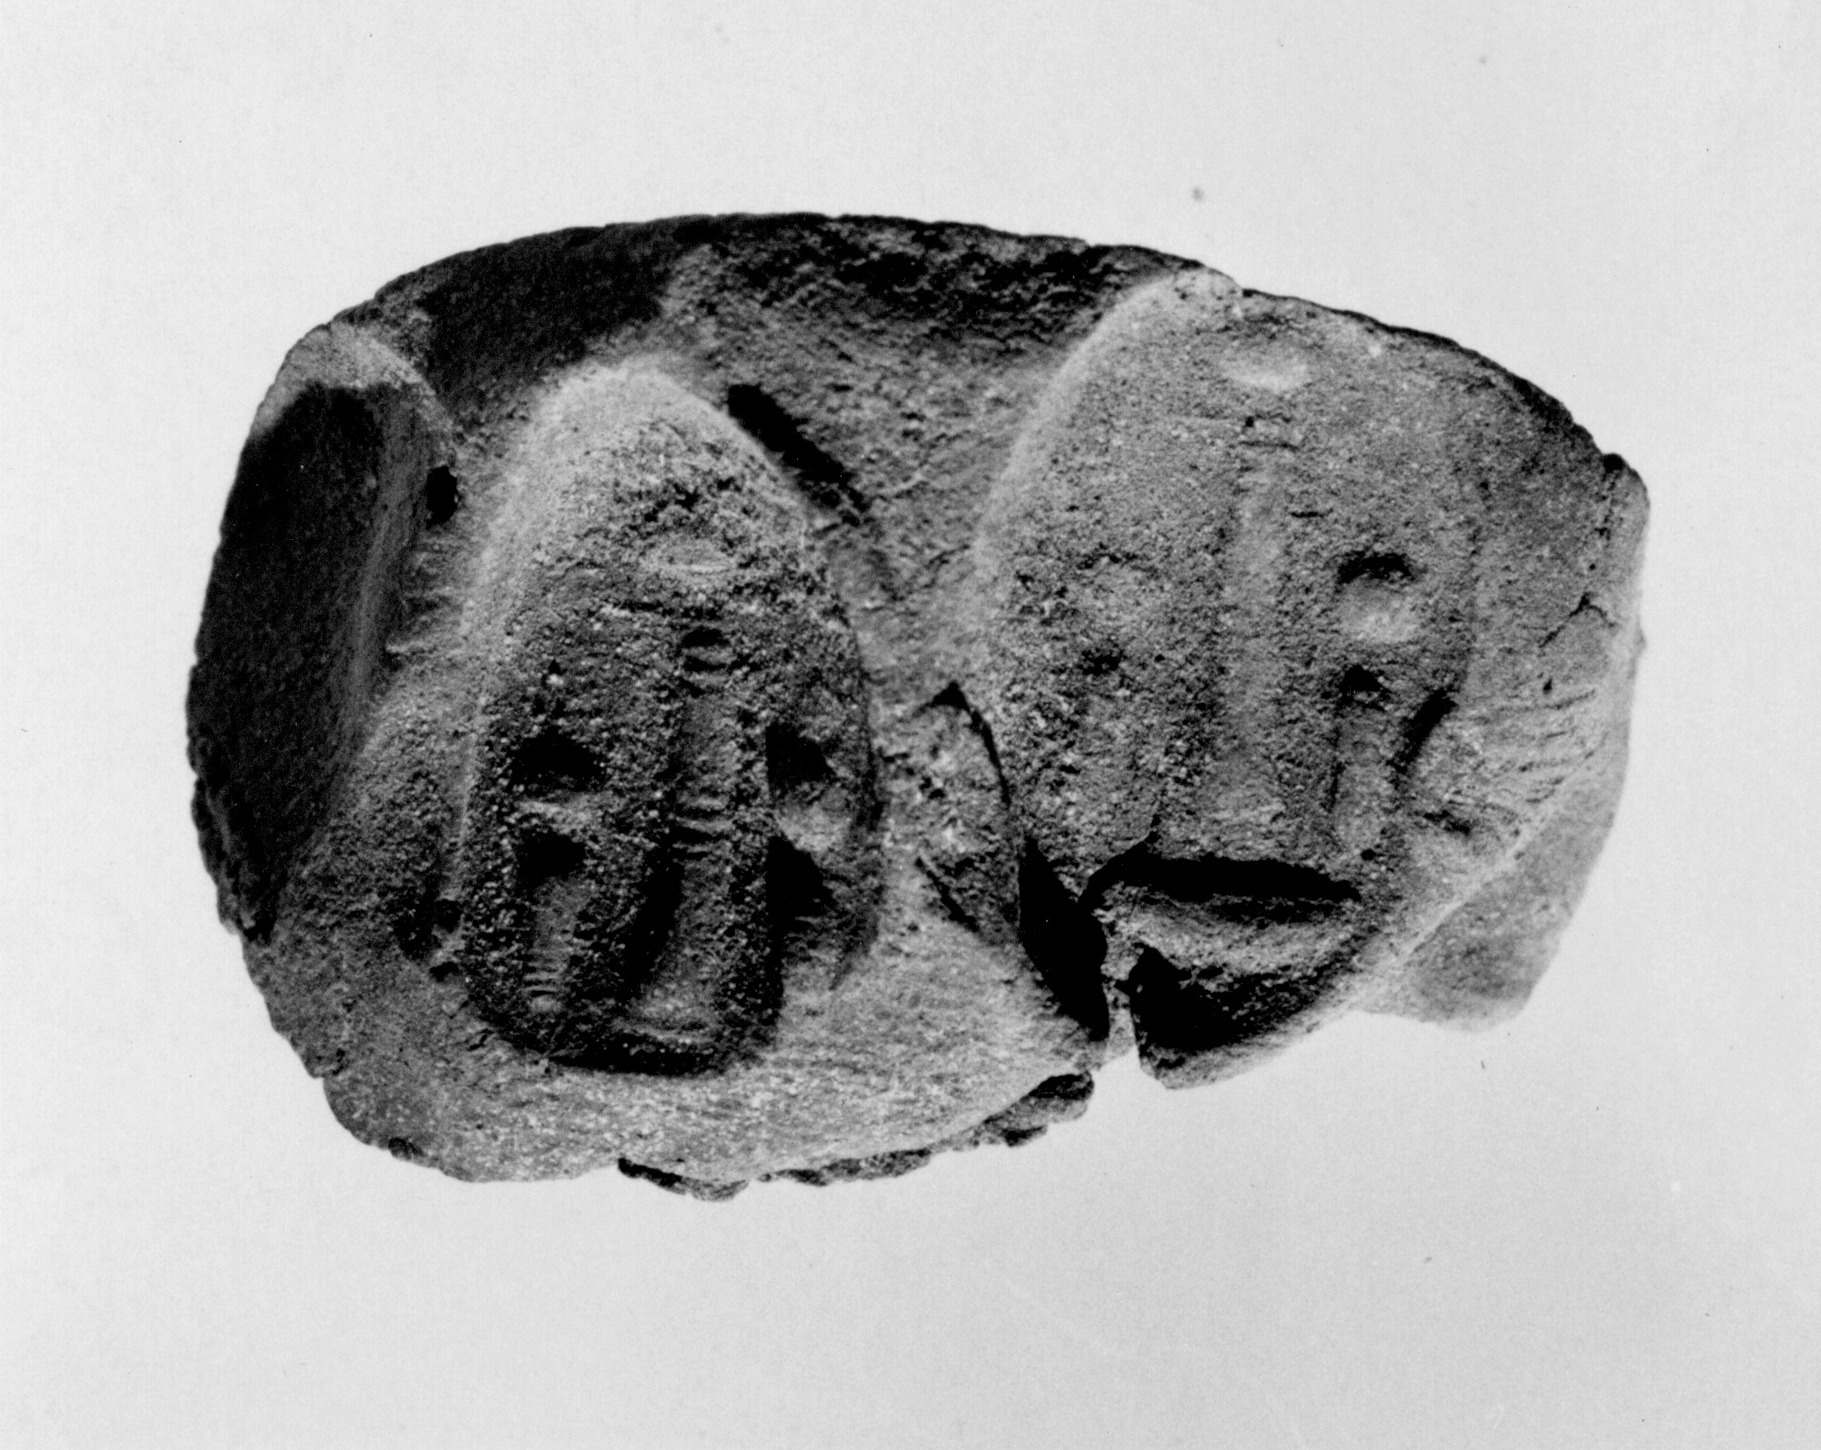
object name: sealing, djed, cobra, sun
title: Document Sealing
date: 1390-1352 BCE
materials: mud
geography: egypt